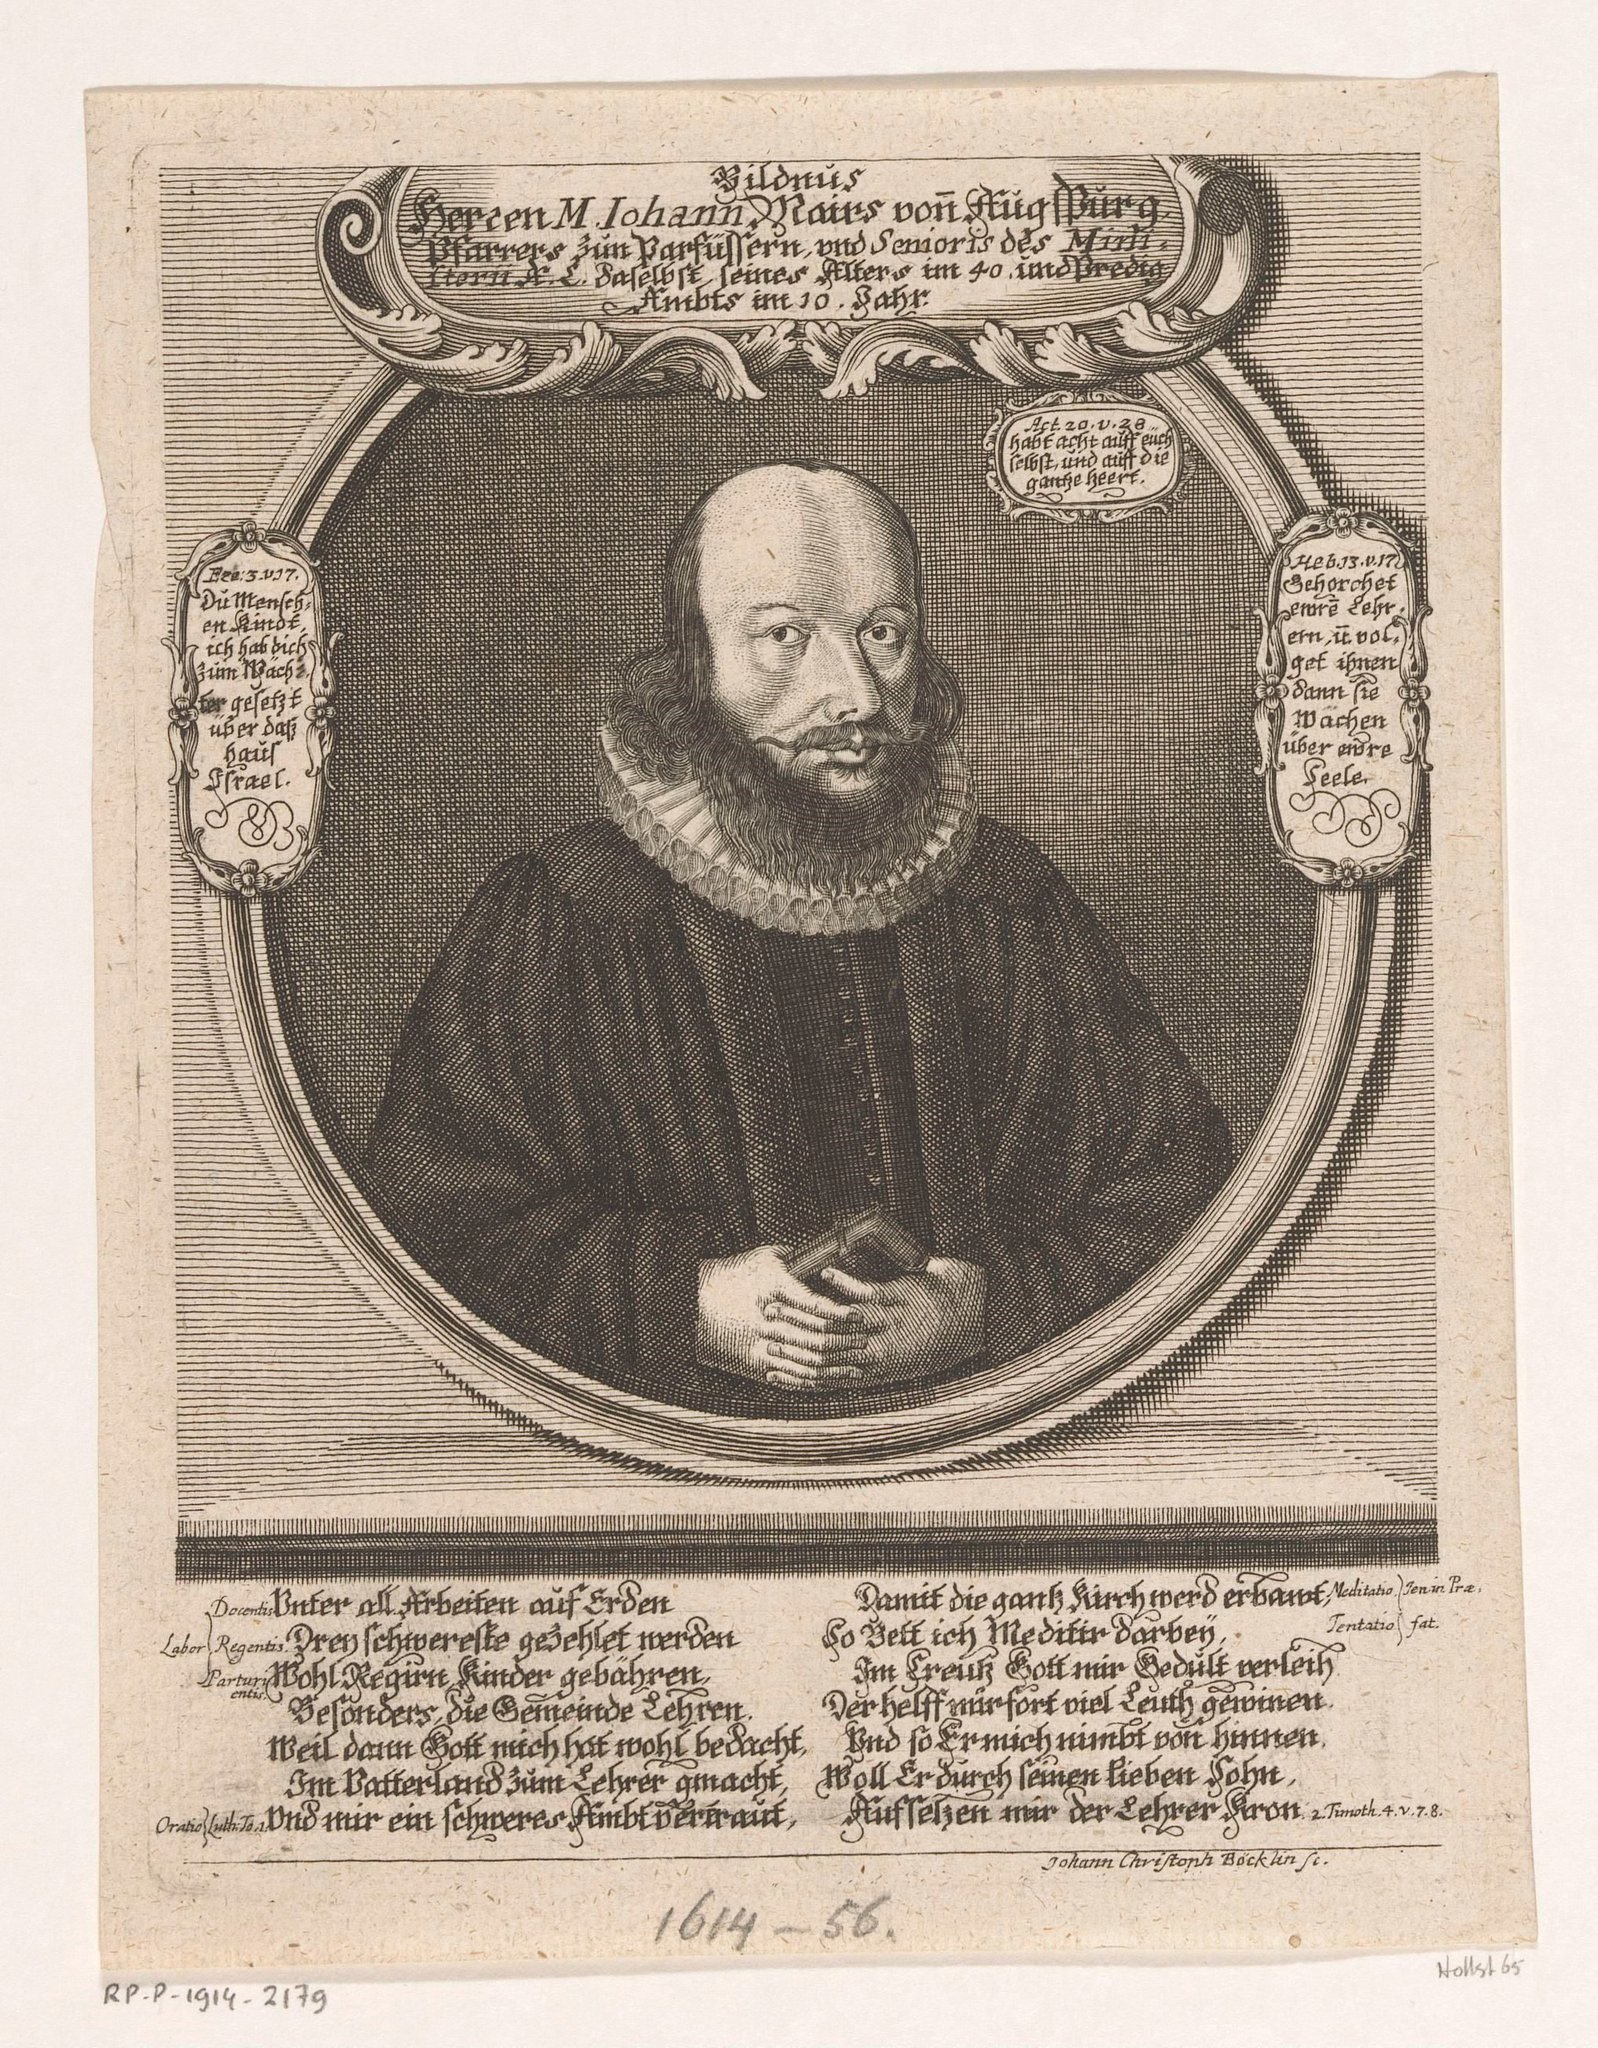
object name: print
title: Portret van Johann Mair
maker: johann christoph boecklin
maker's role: print maker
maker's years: 1657-1709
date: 1667-1709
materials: paper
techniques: engraving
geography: leipzig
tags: augsburg, johann mair, historical persons, book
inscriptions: collector's mark: Lugt 2228